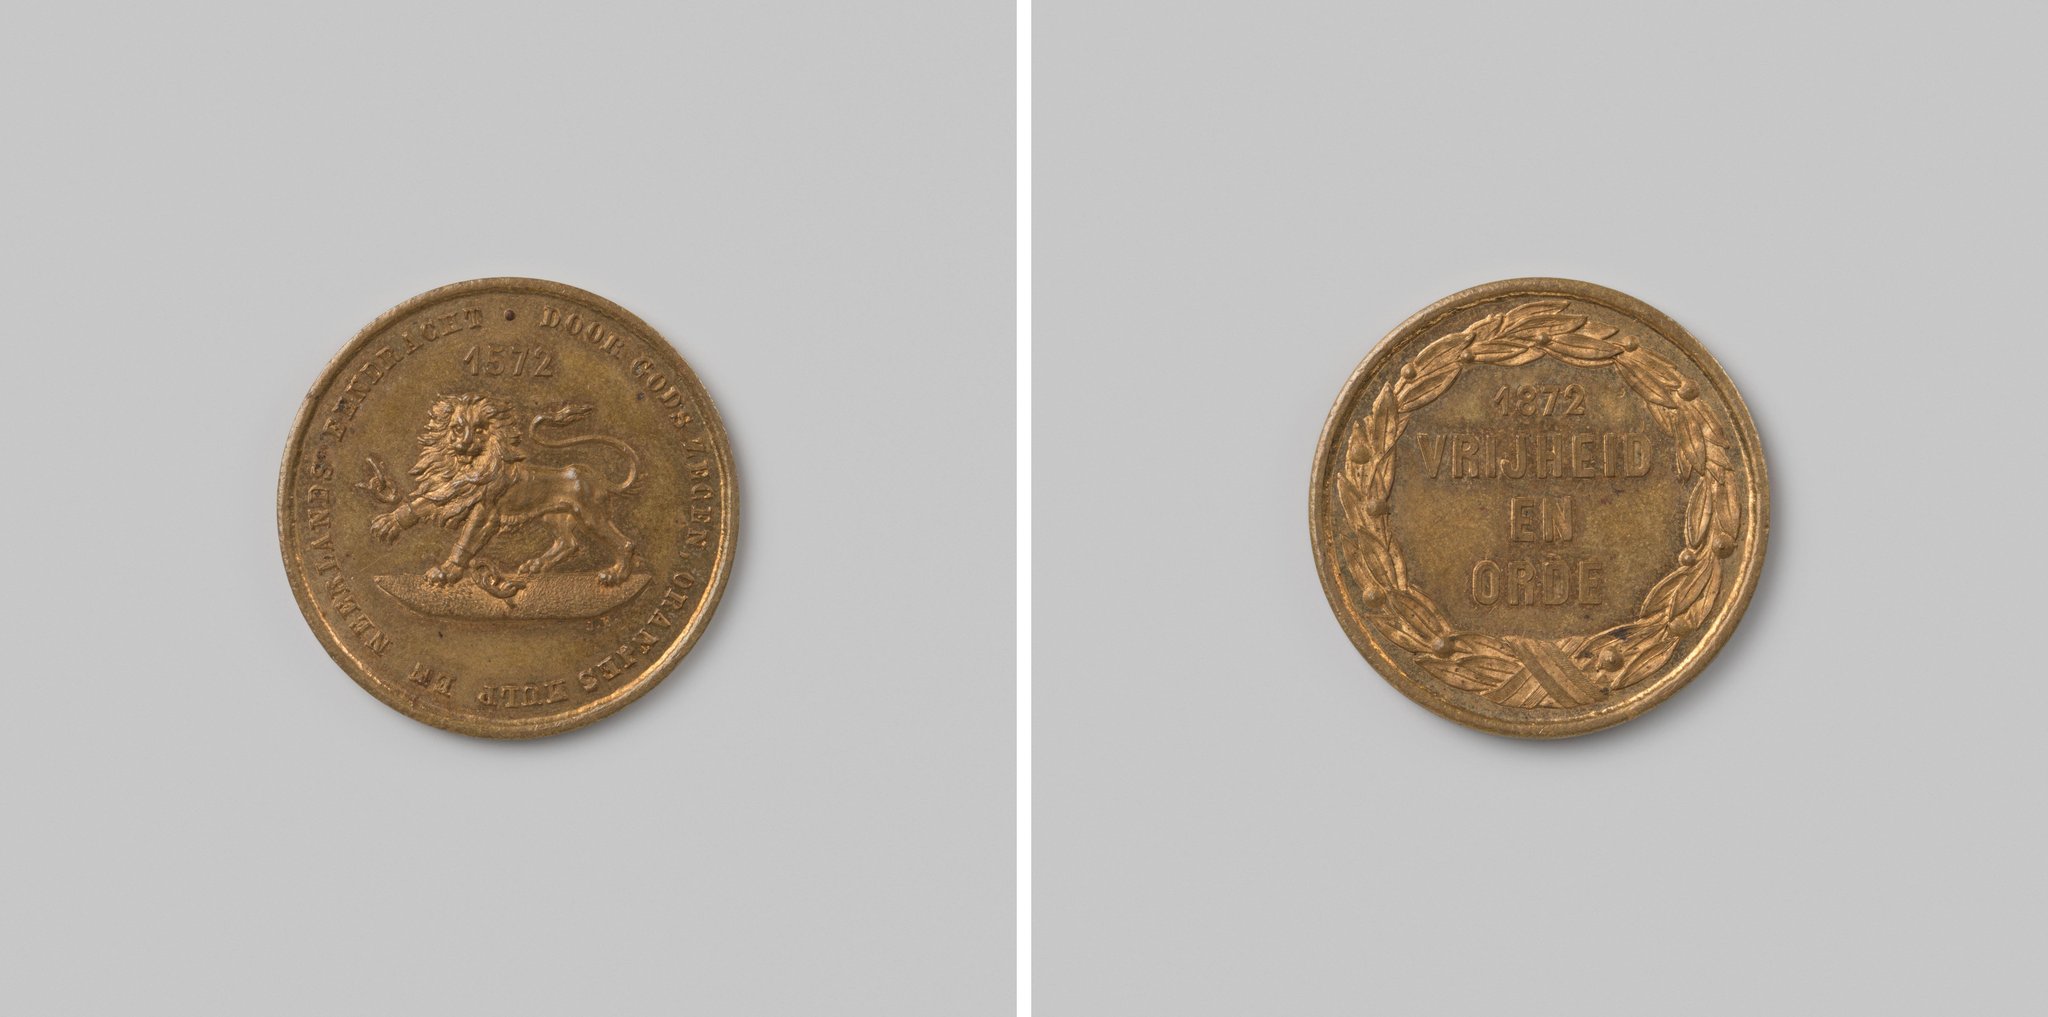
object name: history medal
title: Derde eeuwfeest van de inname van Den Briel, penning uitgegeven door de feestcommissie van Amsterdam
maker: jacob samuel cohen elion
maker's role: draughtsman, painter, print maker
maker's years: 1840-1893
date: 1872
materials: silver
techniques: gilding, striking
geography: amsterdam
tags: amsterdam, brielle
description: Zilveren penning. Voorzijde: leeuw met verbroken kluisters onder jaartal binnen omschrift. Keerzijde: opschrift binnen lauwerkrans